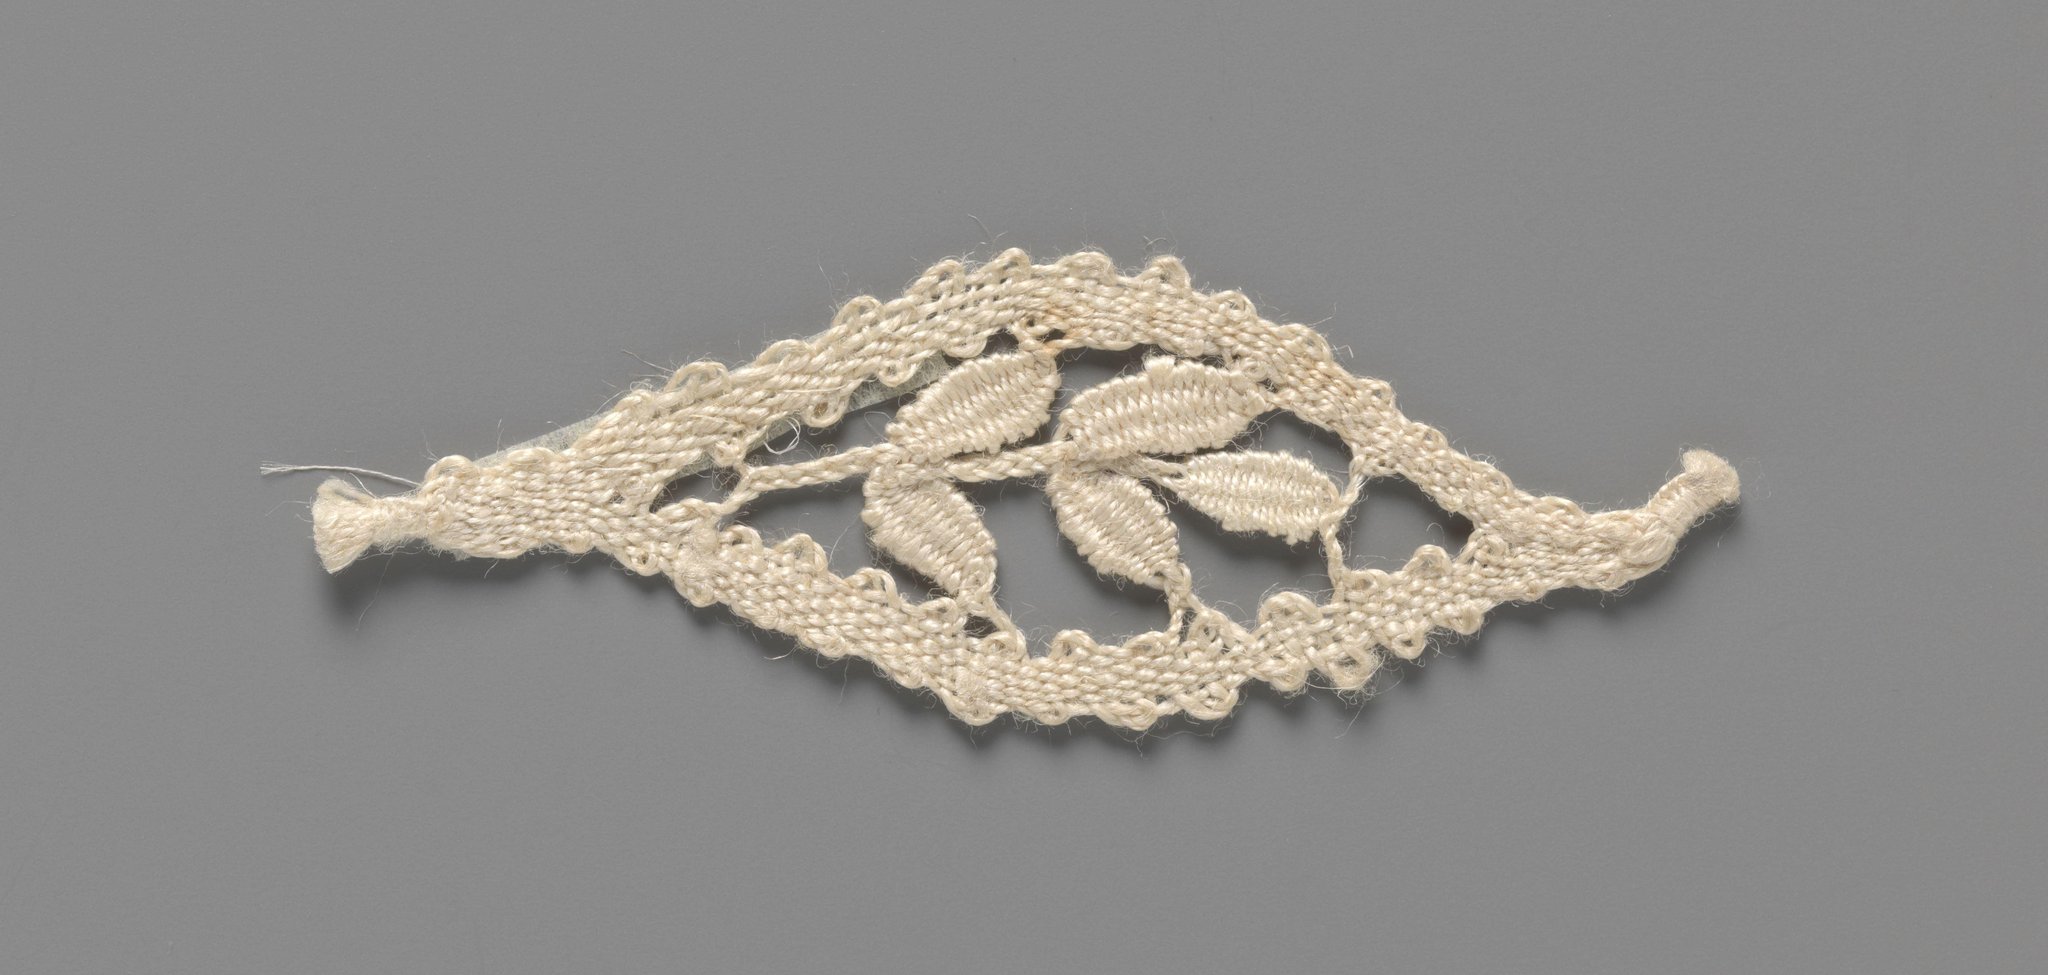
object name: motif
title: Motief van kloskant in de vorm van een spitsovaal met daarin een tak met vijf bladeren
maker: sophia gerardine cenijn-smit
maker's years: 1876-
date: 1914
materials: linen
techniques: lace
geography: amsterdam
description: Motief in de vorm van een spitsovaal van naturelkleurig kloskant: Cluny-kant. De contour van het ovaaltje is gemaakt in linnenslag. Binnen de contour staat een tak met vijf bladeren gemaakt in vormslag. De tak wordt gevormd door een vlechtje.